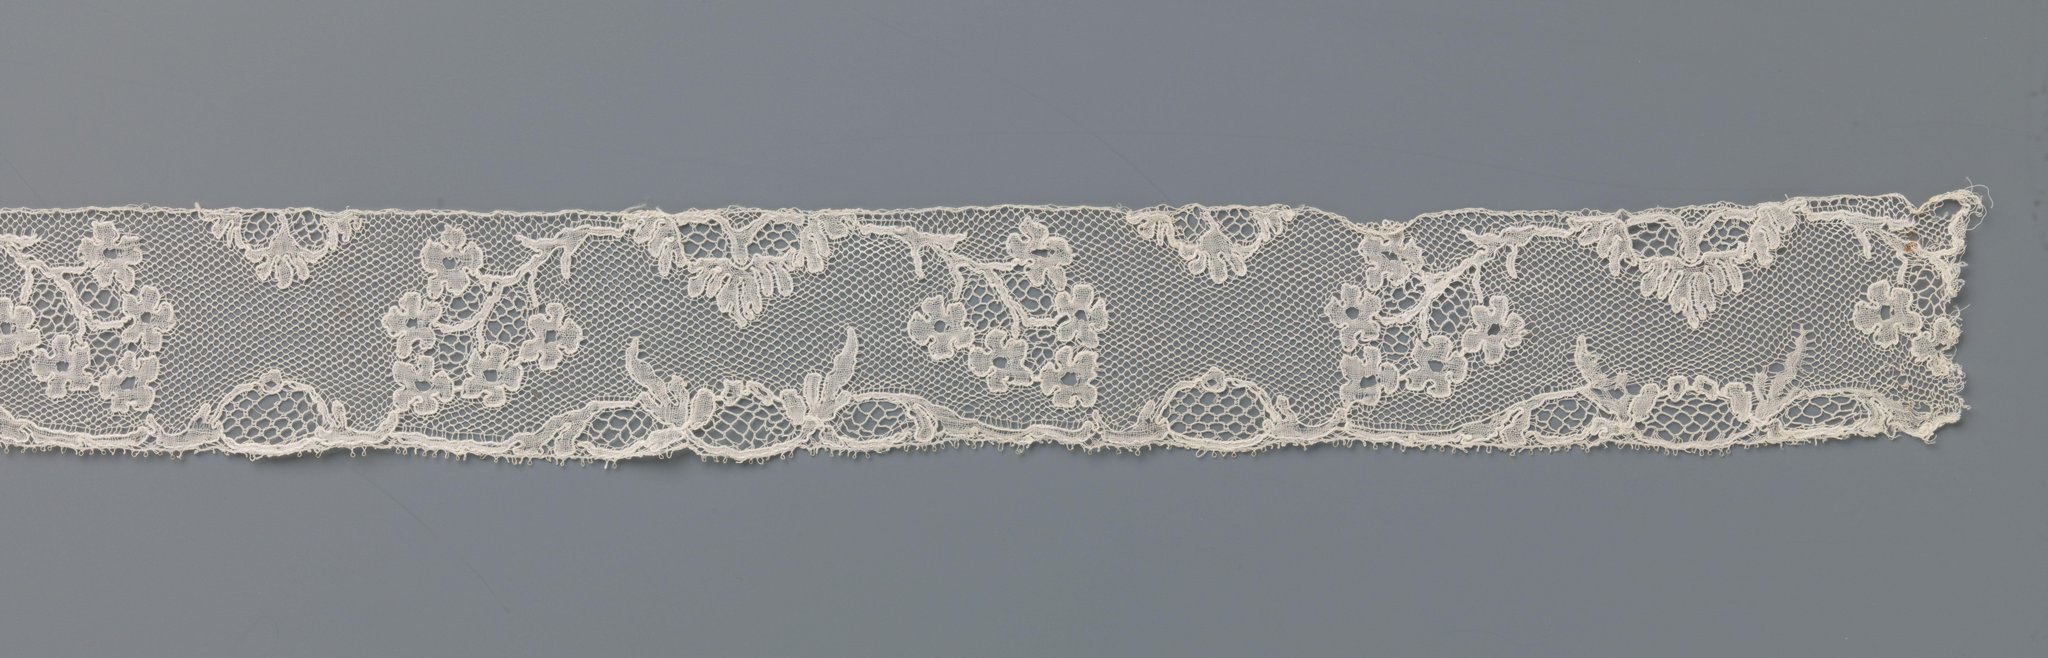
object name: strip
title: Strook kloskant met boogje van vergeet-mij-nietjes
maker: Anonymous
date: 1750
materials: linen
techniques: lace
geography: mechelen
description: Strook naturelkleurige kloskant: Mechelse kant. Het zich herhalende en symmetrische patroon bestaat uit een boogje gevormd door twee takken met vergeet-mij-nietjes, die ontspringen vanuit een gehalveerde bloem langs de bovenzijde van de strook. Middenonder het boogje liggen langs de onderzijde van de strook drie aaneengeschakelde ovale cartouches. Tussen het opeenvolgende patroon met boogjes ligt langs de bovenzijde een iets kleinere gehalveerde bloem en rechts daaronder, langs de onderzijde, een ovale cartouche. De motieven zijn met elkaar verbonden door een fijne maasgrond. De motieven zijn gemaakt in linnenslag met grote uitsparingen als bloemhartjes en met dikkere en glimmende contourdraden. Er zijn twee verschillende siergronden toegepast in de cartouches en tussen de bloemtakjes. Boven- en onderzijde zijn recht afgewerkt, met langs de onderzijde picots.